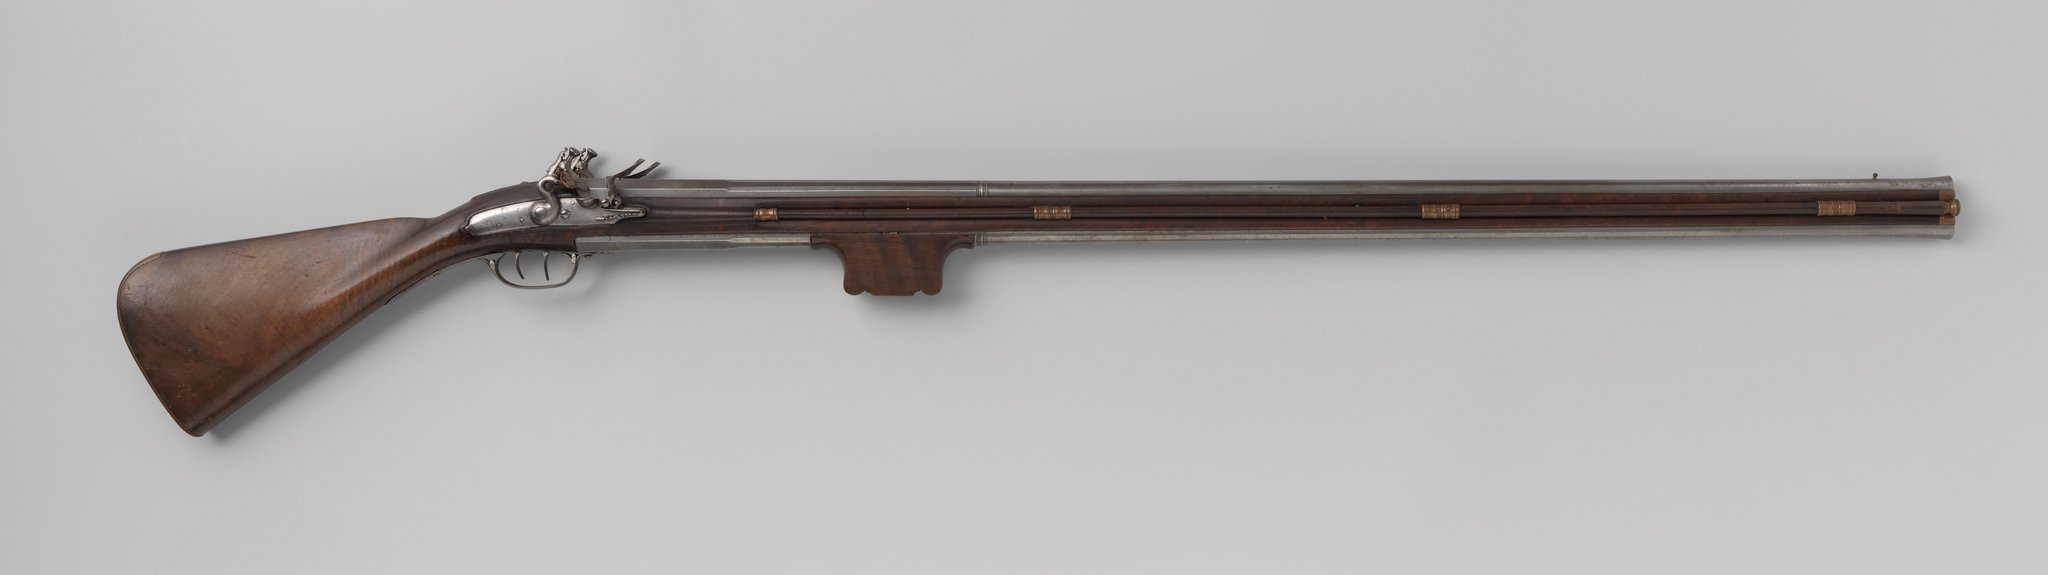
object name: flintlock pistol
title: Dubbelloops vuursteenpistool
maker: Anonymous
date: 1665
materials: brass, copper, iron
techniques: cutting